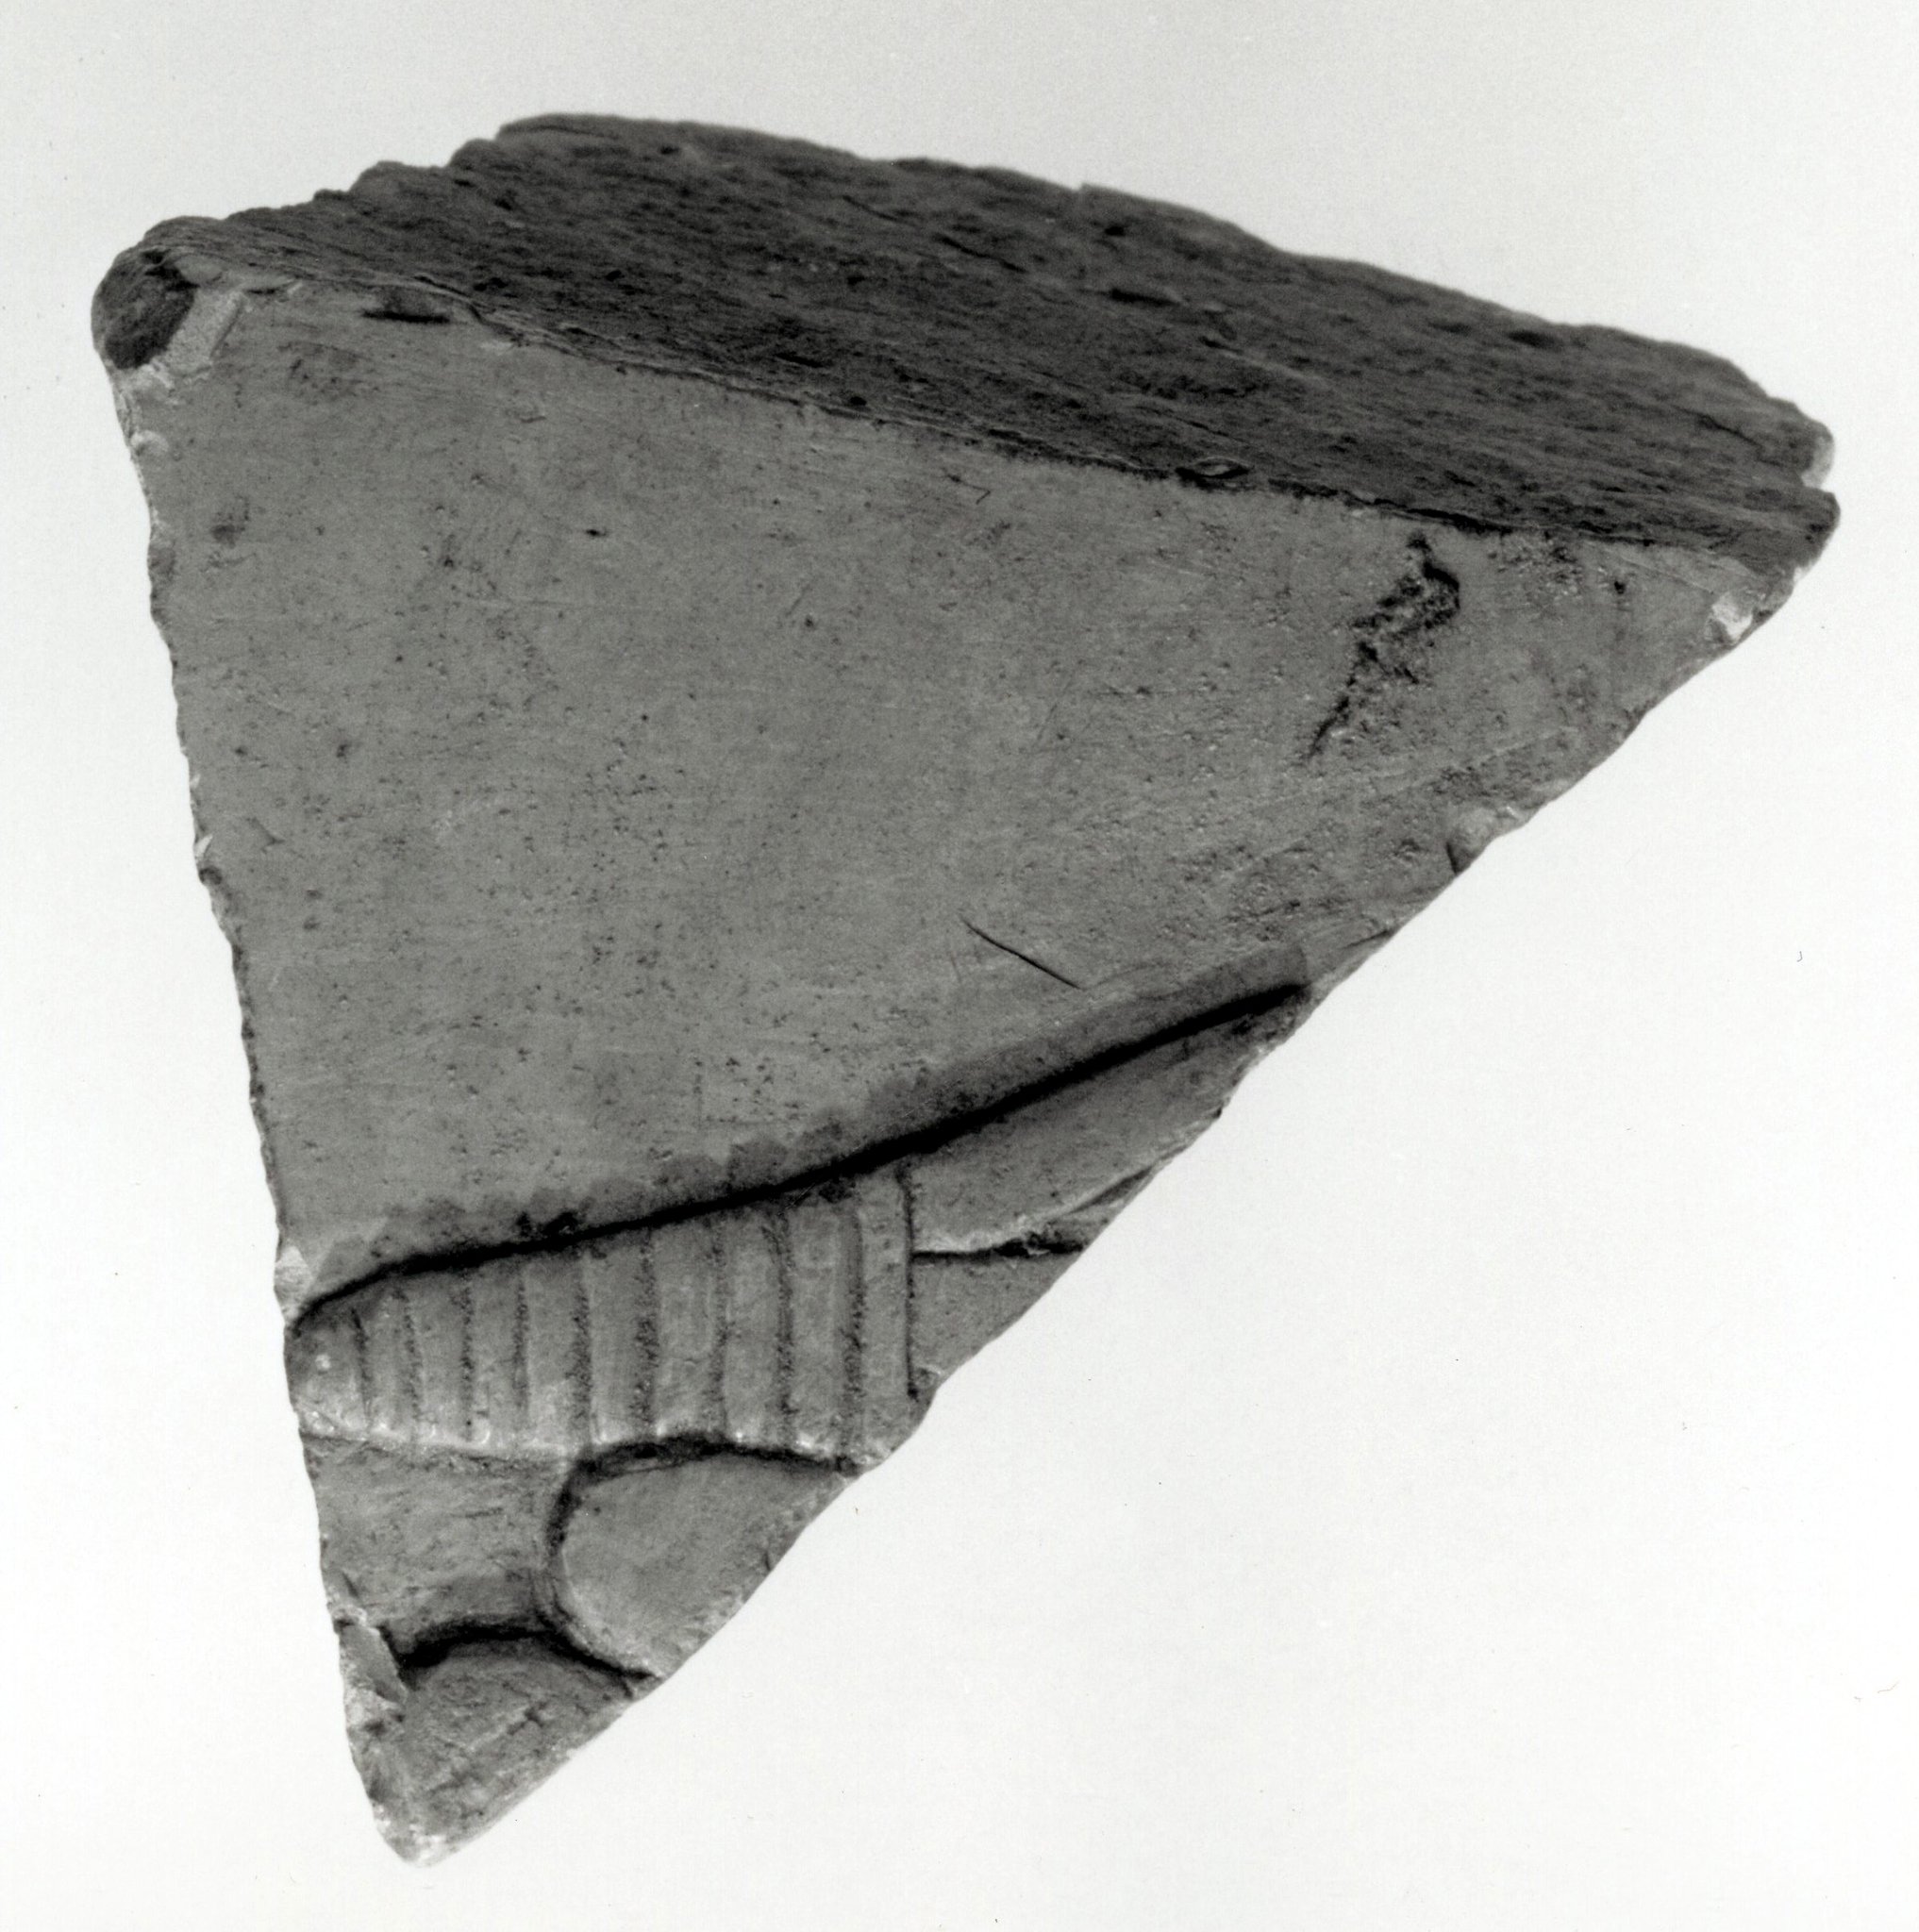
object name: relief, tomb of nespekashuty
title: Raised relief fragment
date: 664-610 BCE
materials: limestone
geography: egypt